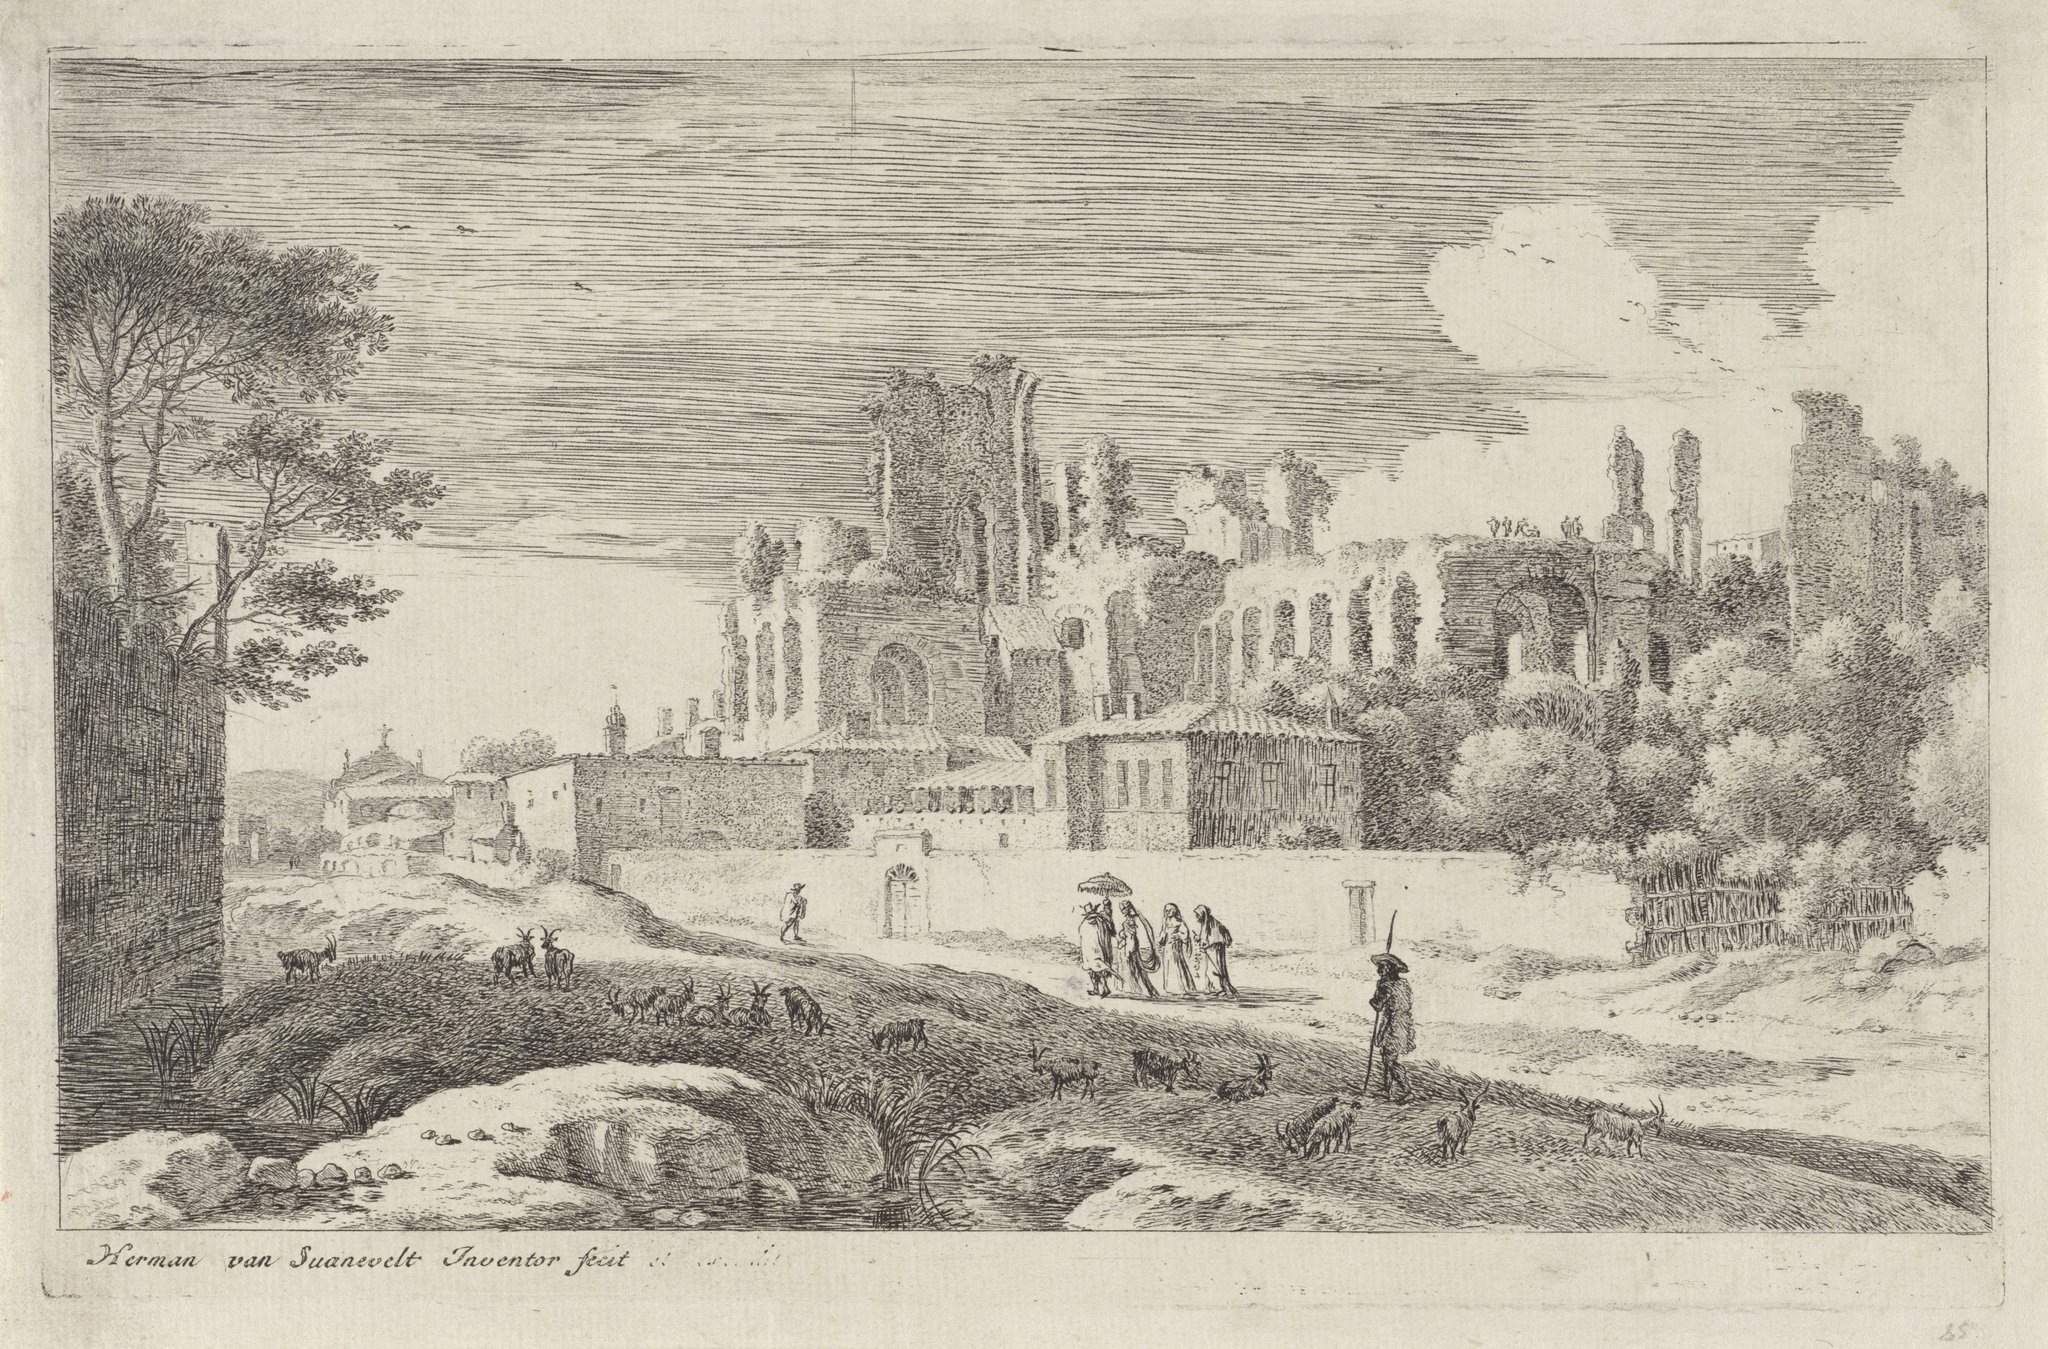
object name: print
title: Twaalf landschappen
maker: herman van swanevelt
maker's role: draughtsman, painter, print maker, publisher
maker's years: 1603-1655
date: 1650-1705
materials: paper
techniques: etching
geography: paris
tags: landscapes, herding, herdsman, herdswoman, shepherd, shepherdess, cowherd, etc., ruin of a building ~ architecture, landscape with ruins, brook, goat, 'en route', traveller under way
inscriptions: collector's mark: Lugt 2228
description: Op een landweg voor een ommuurd gebouwencomplex met enkele ruïnes lopen enkele wandelaars. Bij een beekje links is een kudde geiten met een herder te zien.